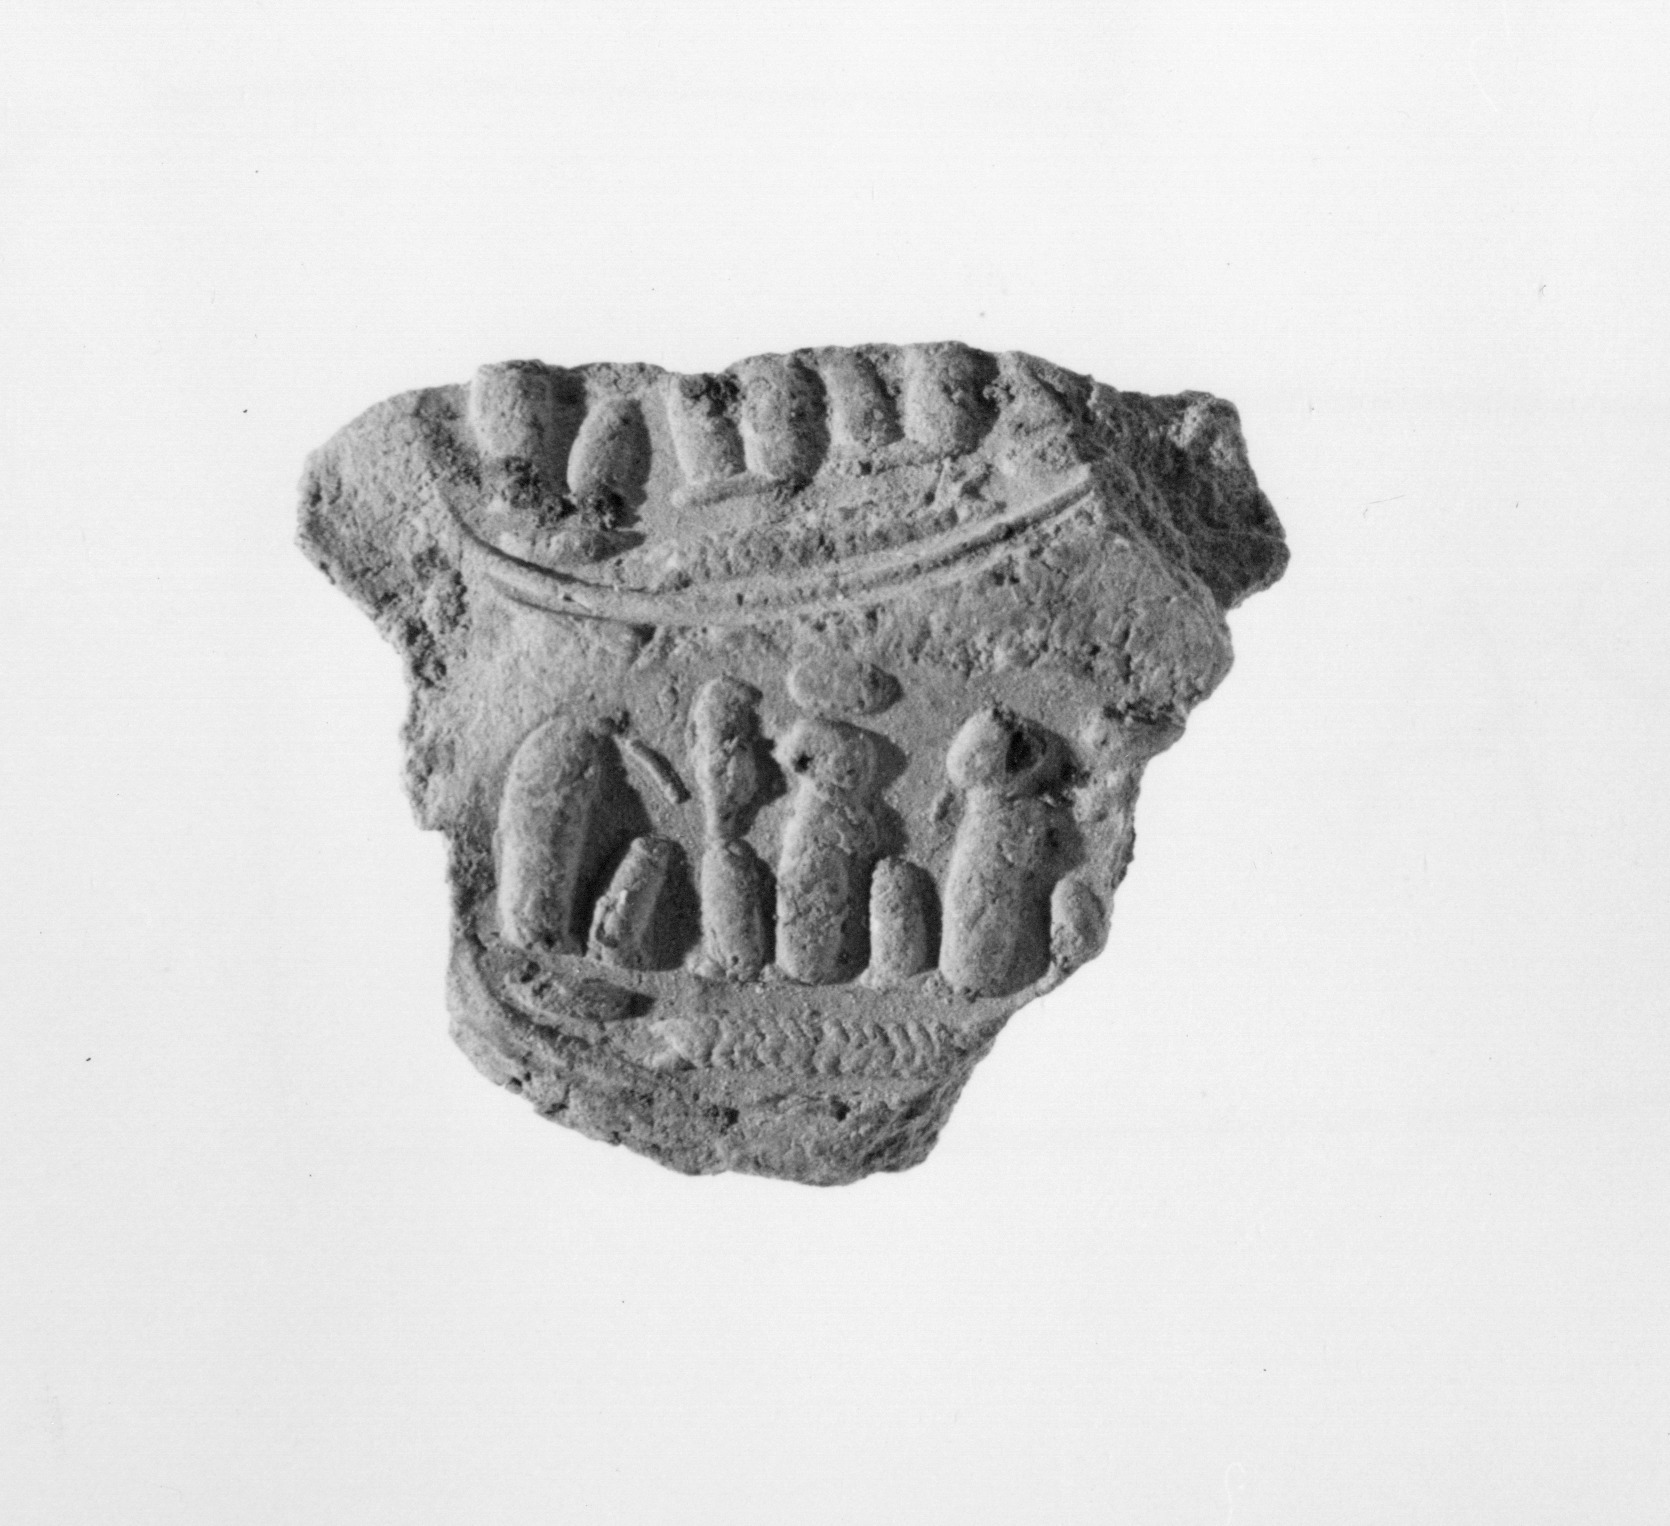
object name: sealing, nebmaatre, amenhotep iii, thoth, ptah, re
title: Document Sealing With the Throne Name of Amenhotep III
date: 1390-1352 BCE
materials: mud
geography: egypt